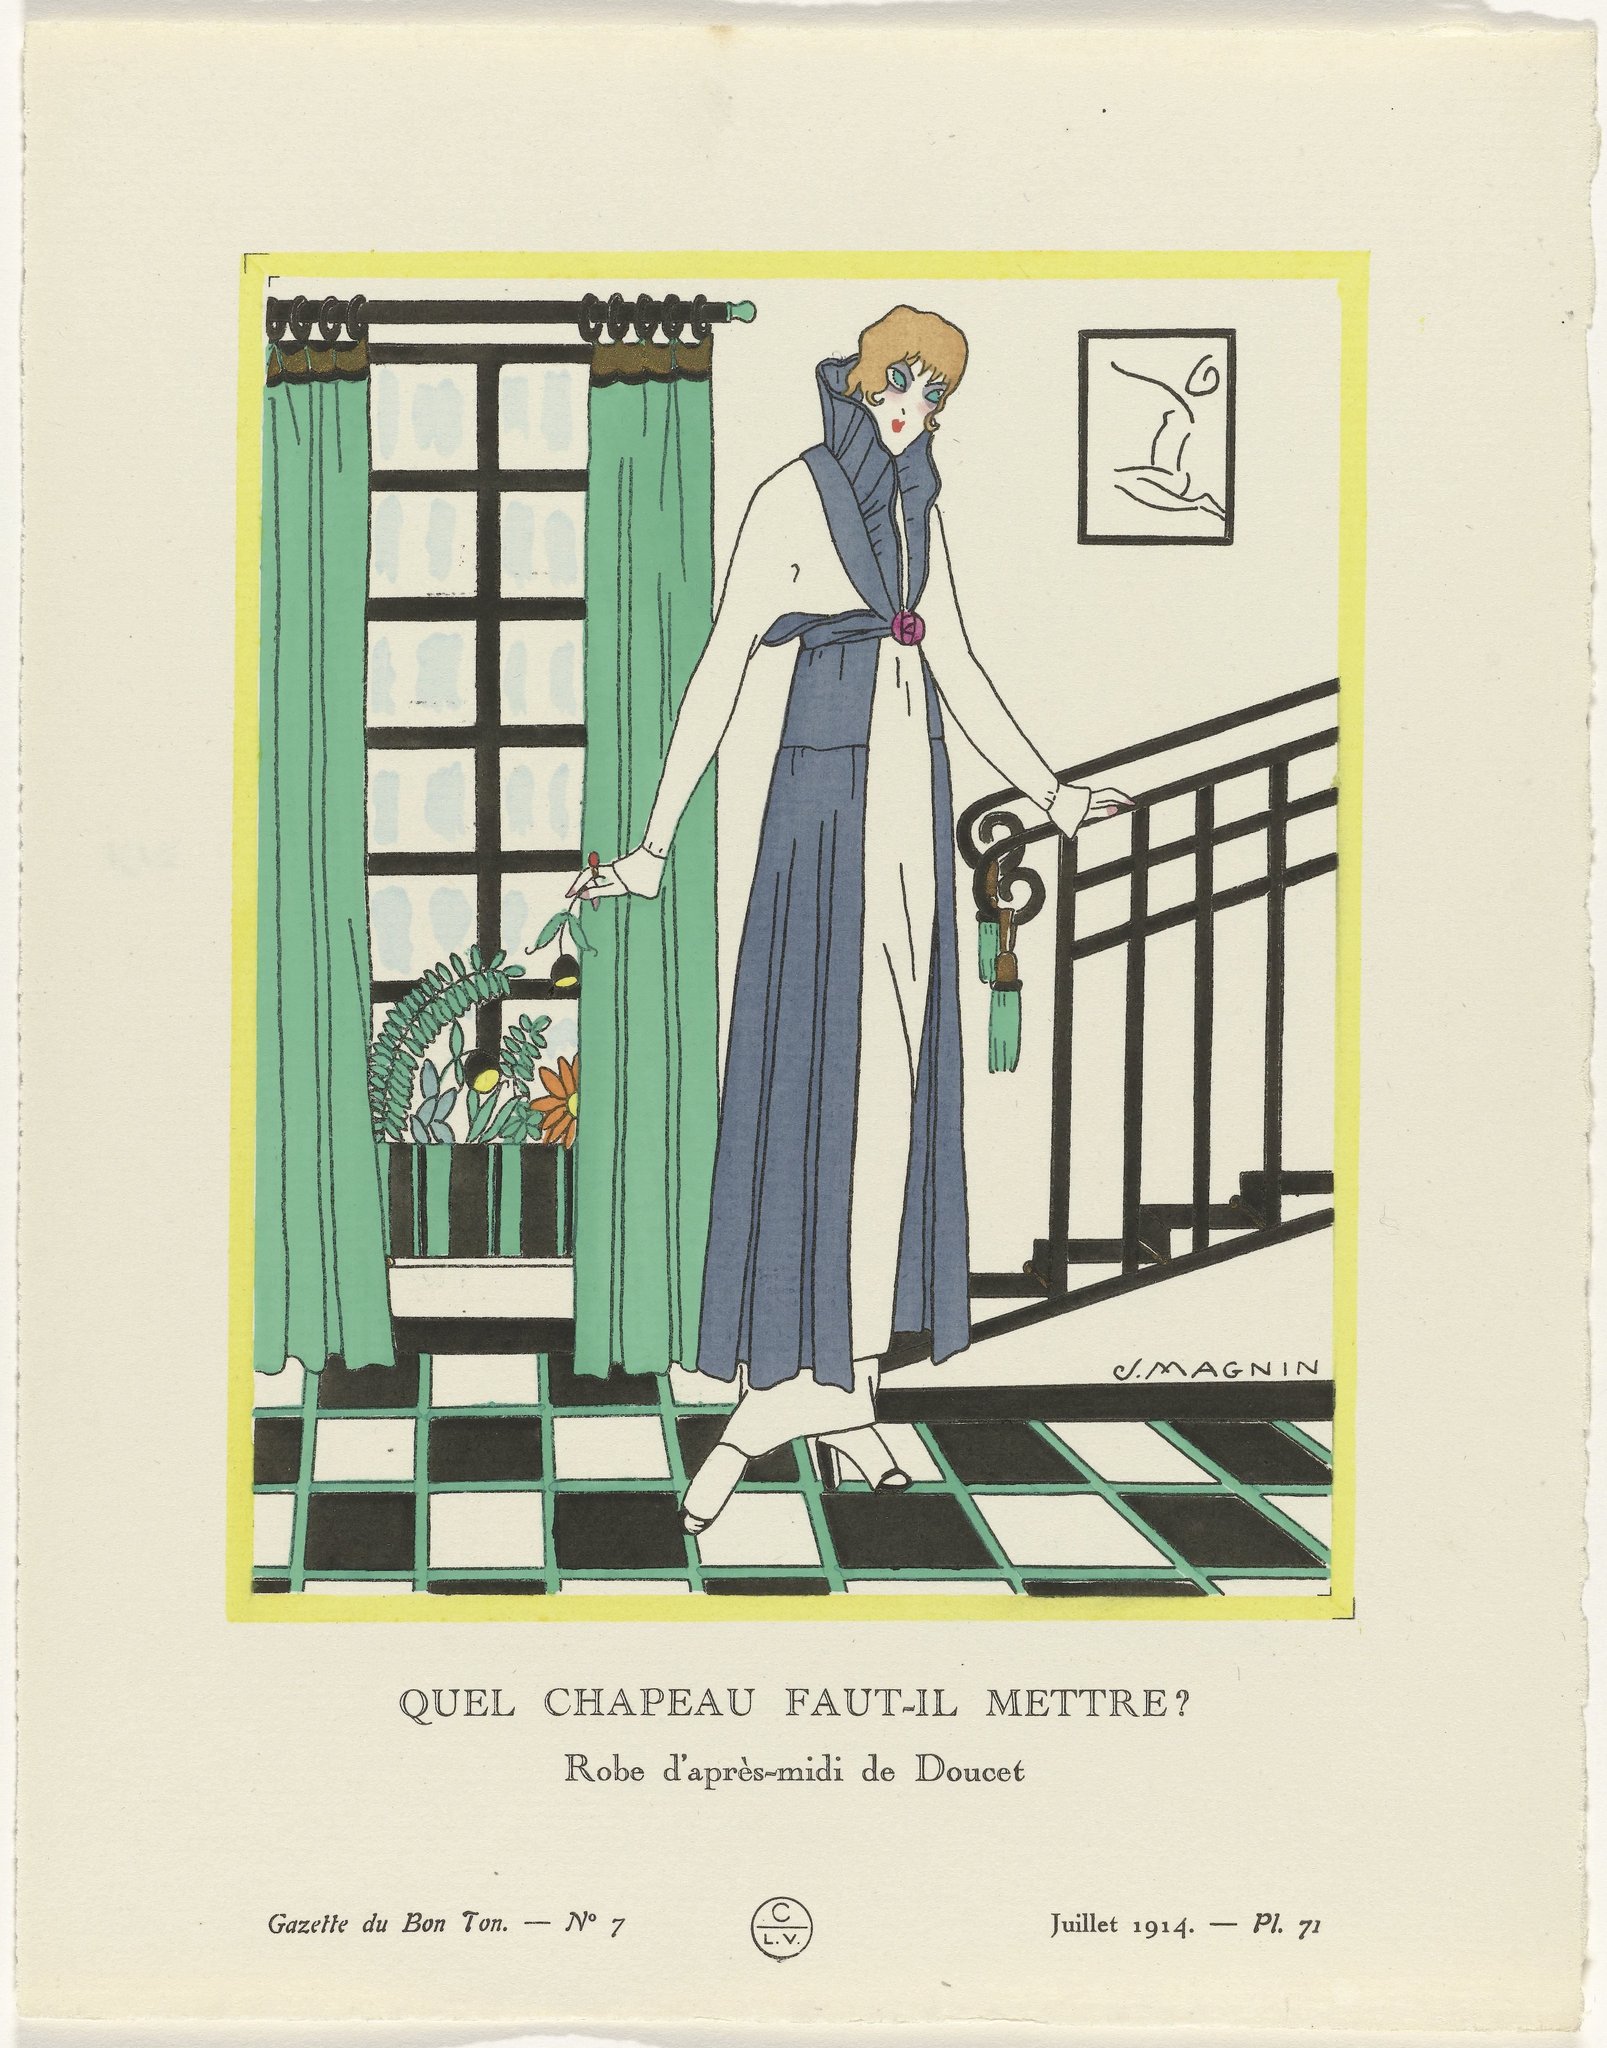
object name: fashion print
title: Gazette du Bon Ton, 1914 - No. 7, Pl. 71: Quel chapeau faut-il mettre? / Robe d'après-midi de Doucet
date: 1914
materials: paper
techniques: hand coloring, letterpress printing, lithograph, pochoir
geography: paris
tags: dress, gown: day dress (+ women's clothes), fashion plates, interior of the house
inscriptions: date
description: Vrouw in blauw/witte middagjapon van Doucet met een hoge gesmokte kraag, staand in een hal bij een trap. Planche 71 uit Gazette du Bon Ton 1914, No. 7. Uitleg over de kleding op pagina "Explication des Planches".